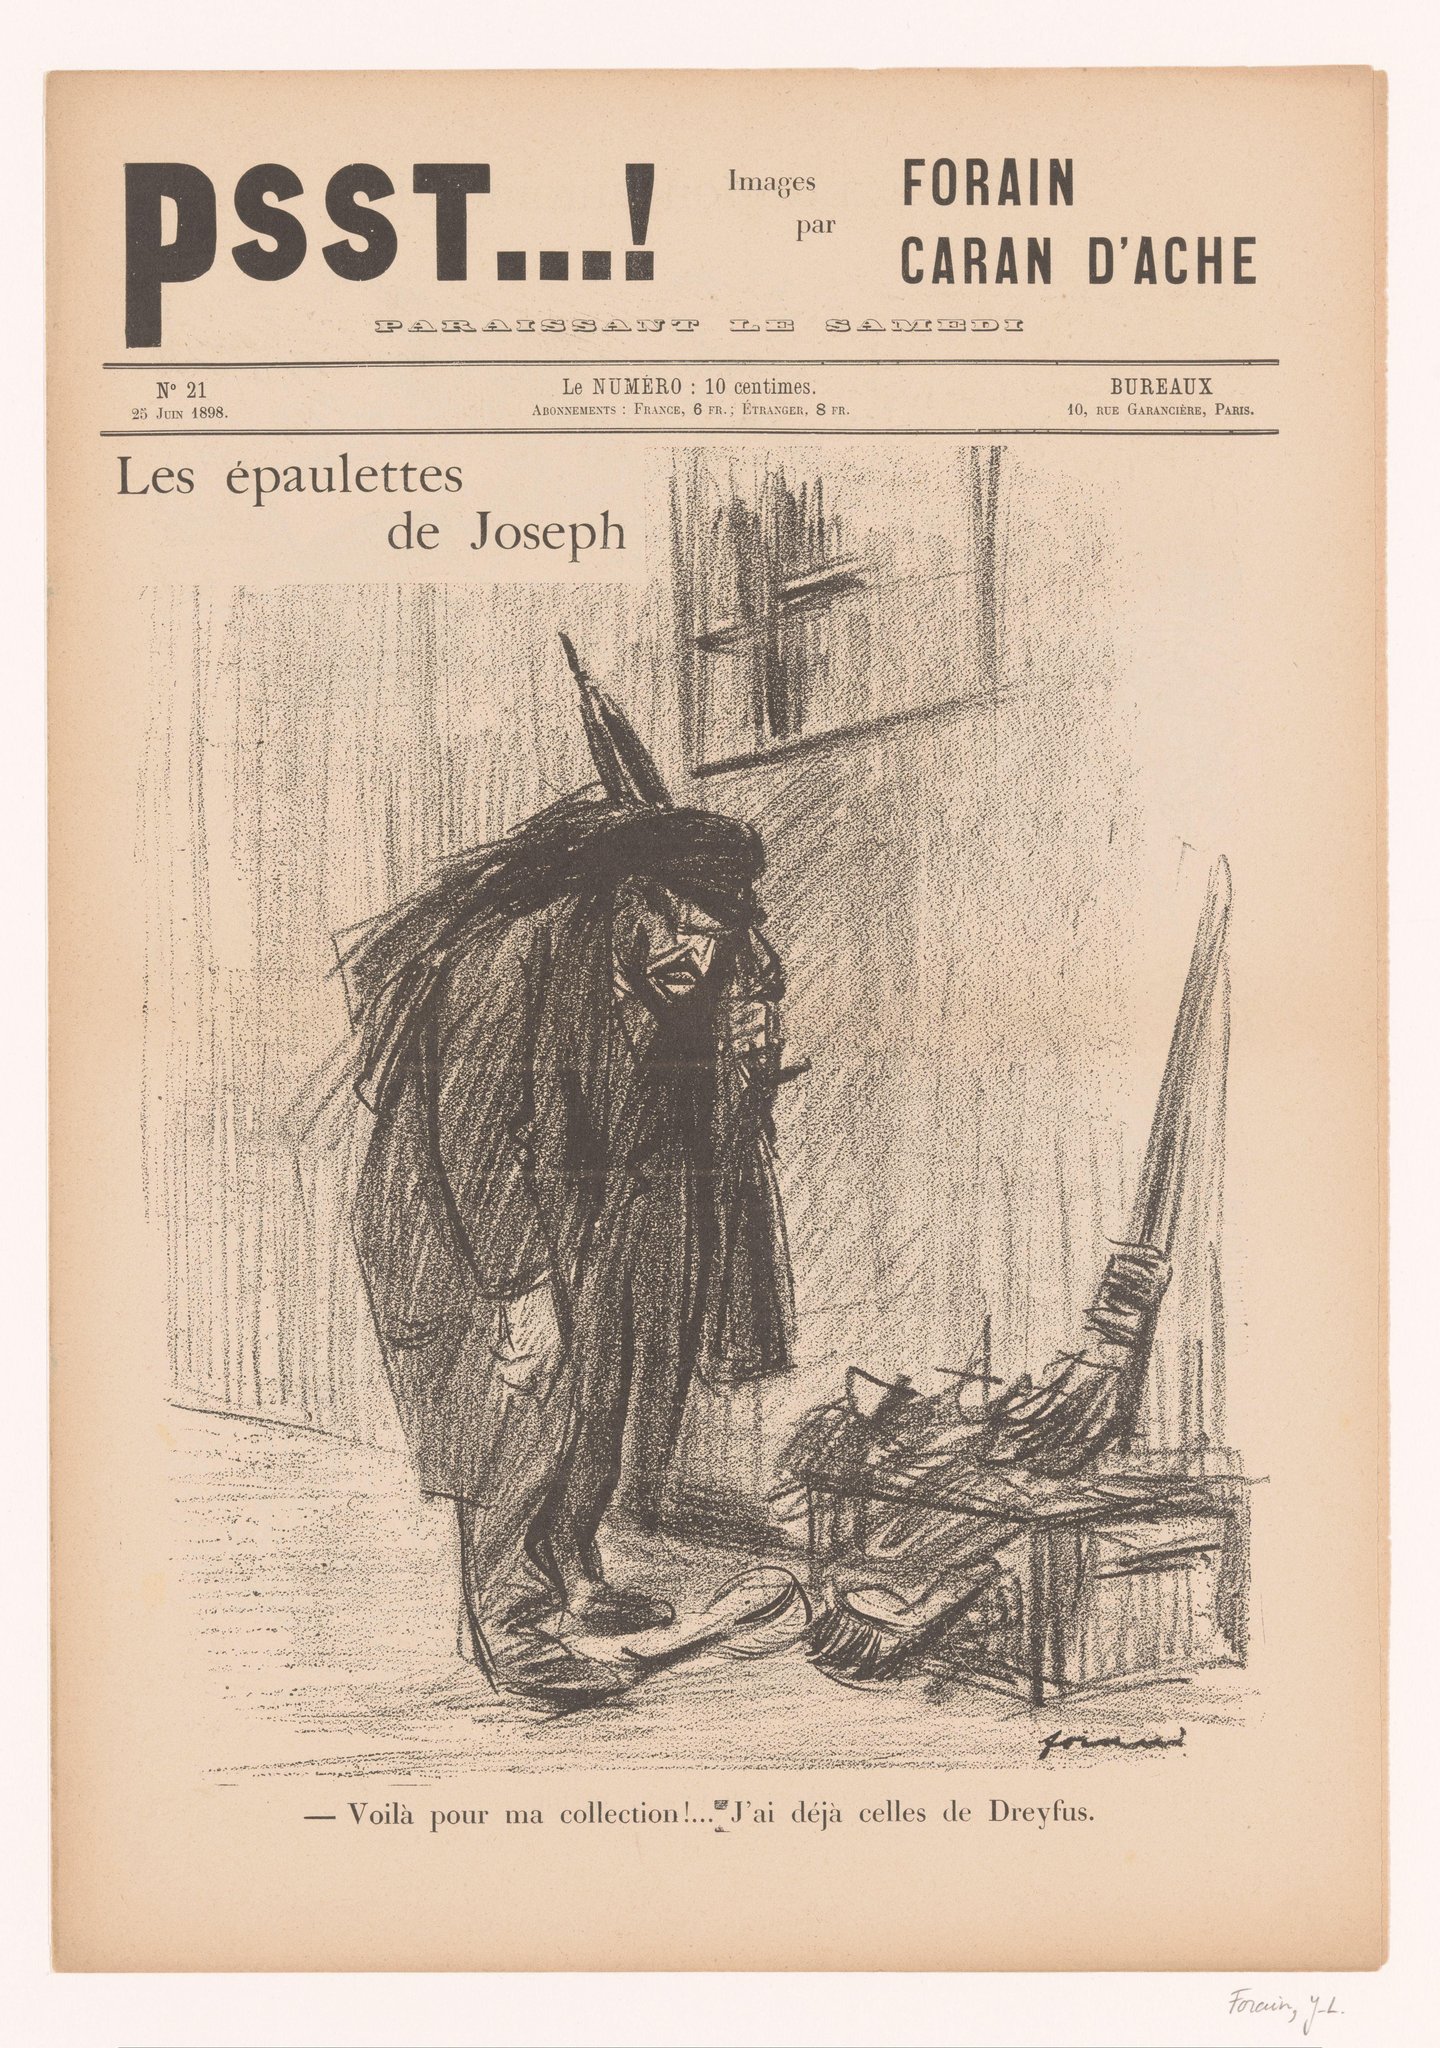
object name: print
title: Karikatuur van Joseph Reinach als Joodse schooier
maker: jean-louis forain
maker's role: painter, print maker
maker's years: 1852-1931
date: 1898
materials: paper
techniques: lithograph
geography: paris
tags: paris, politician, caricatures (human types), historical persons, political caricatures and satires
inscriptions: date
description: Prent gebruikt voor: Psst...!, nr. 21, 25 juni 1898. Psst..! was een politieke weekkrant met antisemitische en anti-Dreyfus cartoons.